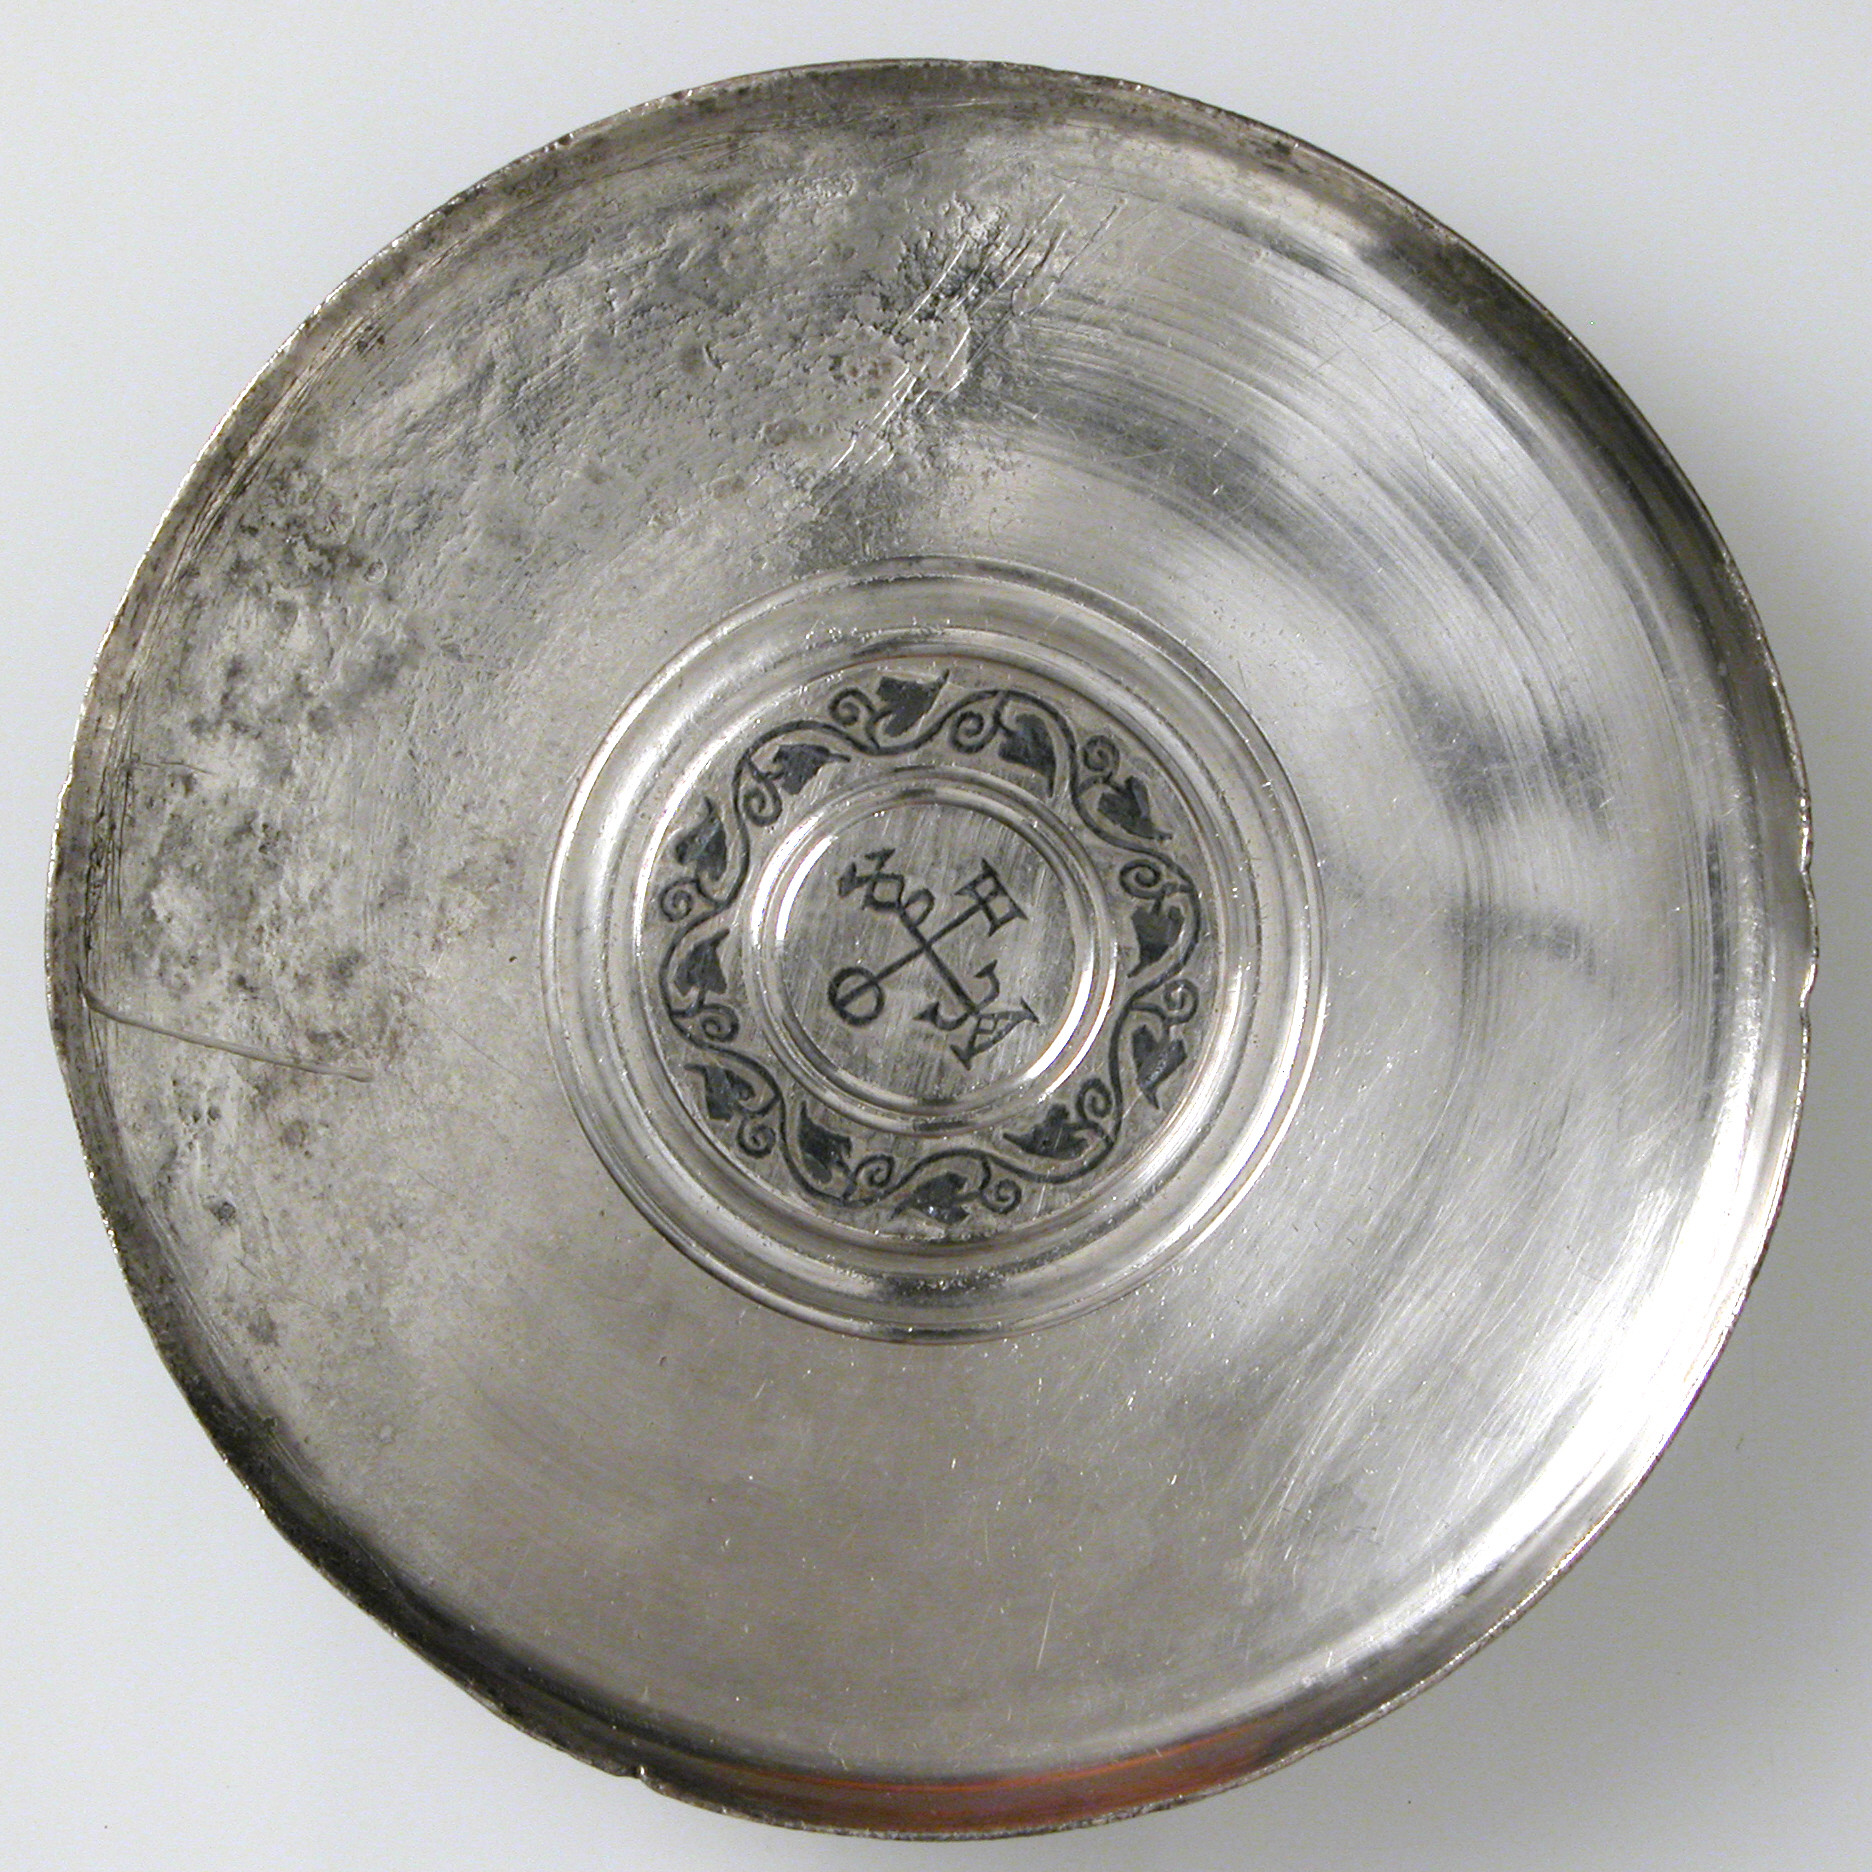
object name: plate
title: Plate with Monogram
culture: byzantine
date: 610-613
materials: niello, silver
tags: insignia